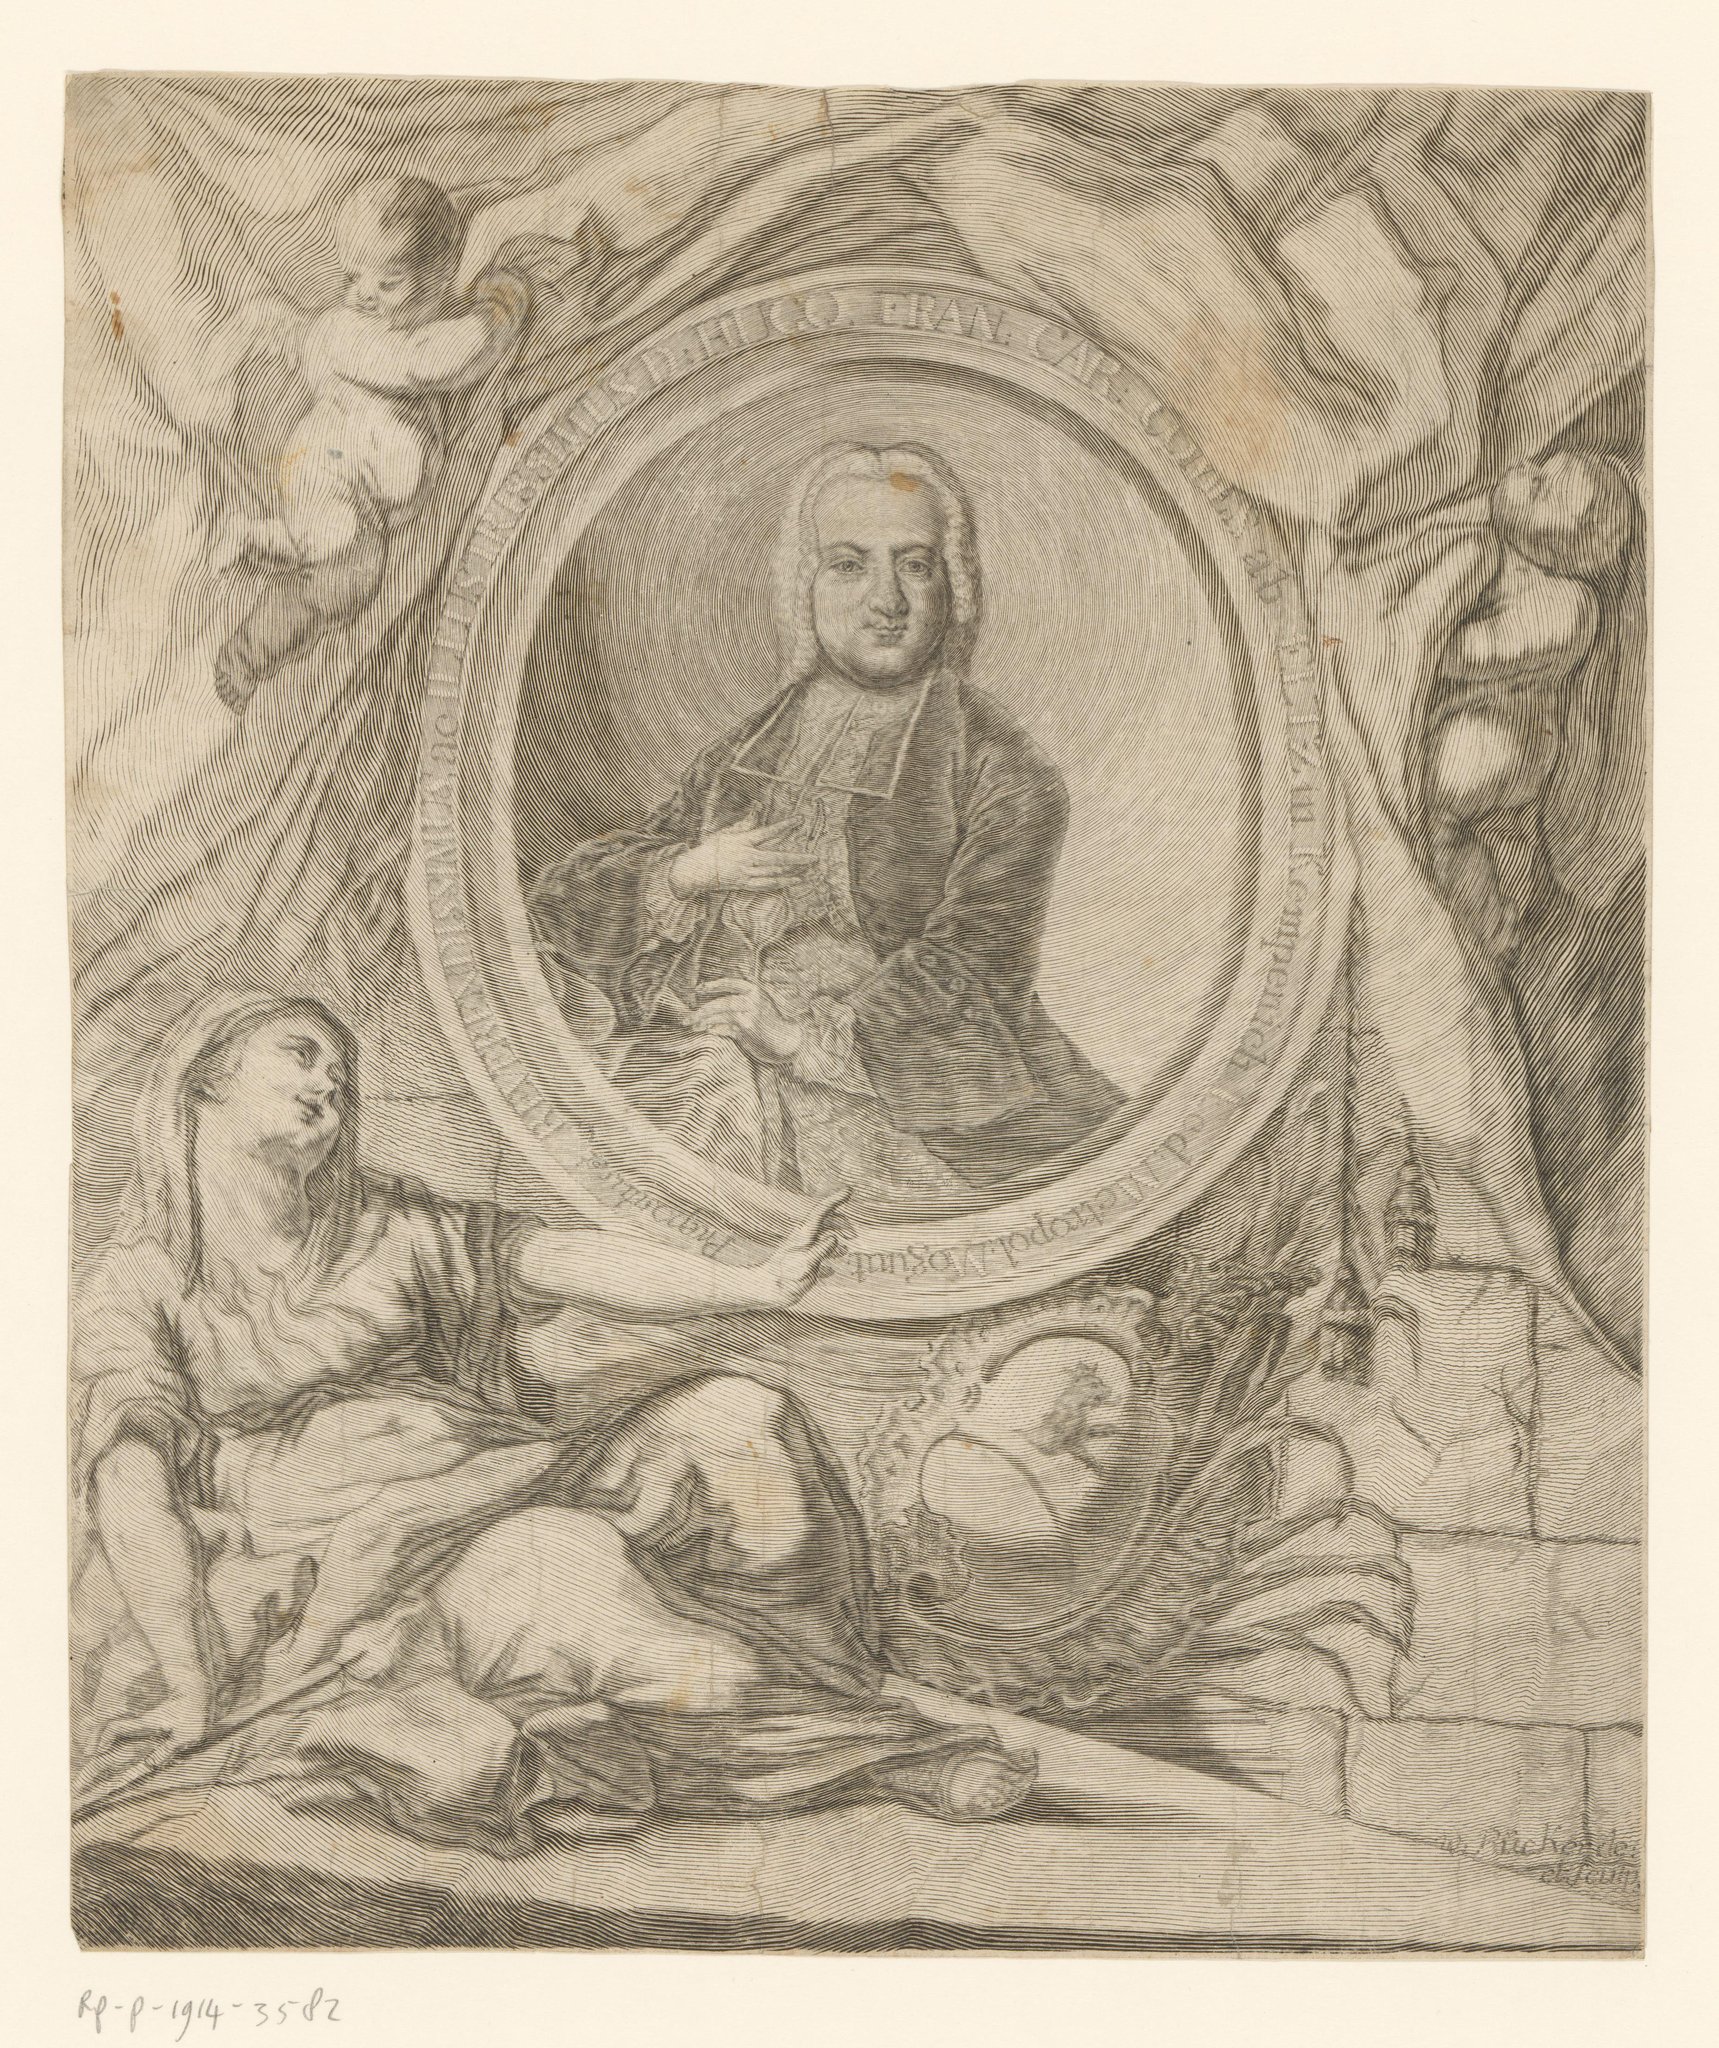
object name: print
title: Portret van Hugo Franz Carl von und zu Eltz-Kempenich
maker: wilhelm christian rücker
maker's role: print maker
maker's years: -1774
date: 1700-1774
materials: paper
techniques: engraving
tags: historical persons, cupids: 'amores', 'amoretti', 'putti', armorial bearing, heraldry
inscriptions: collector's mark: Lugt 2228